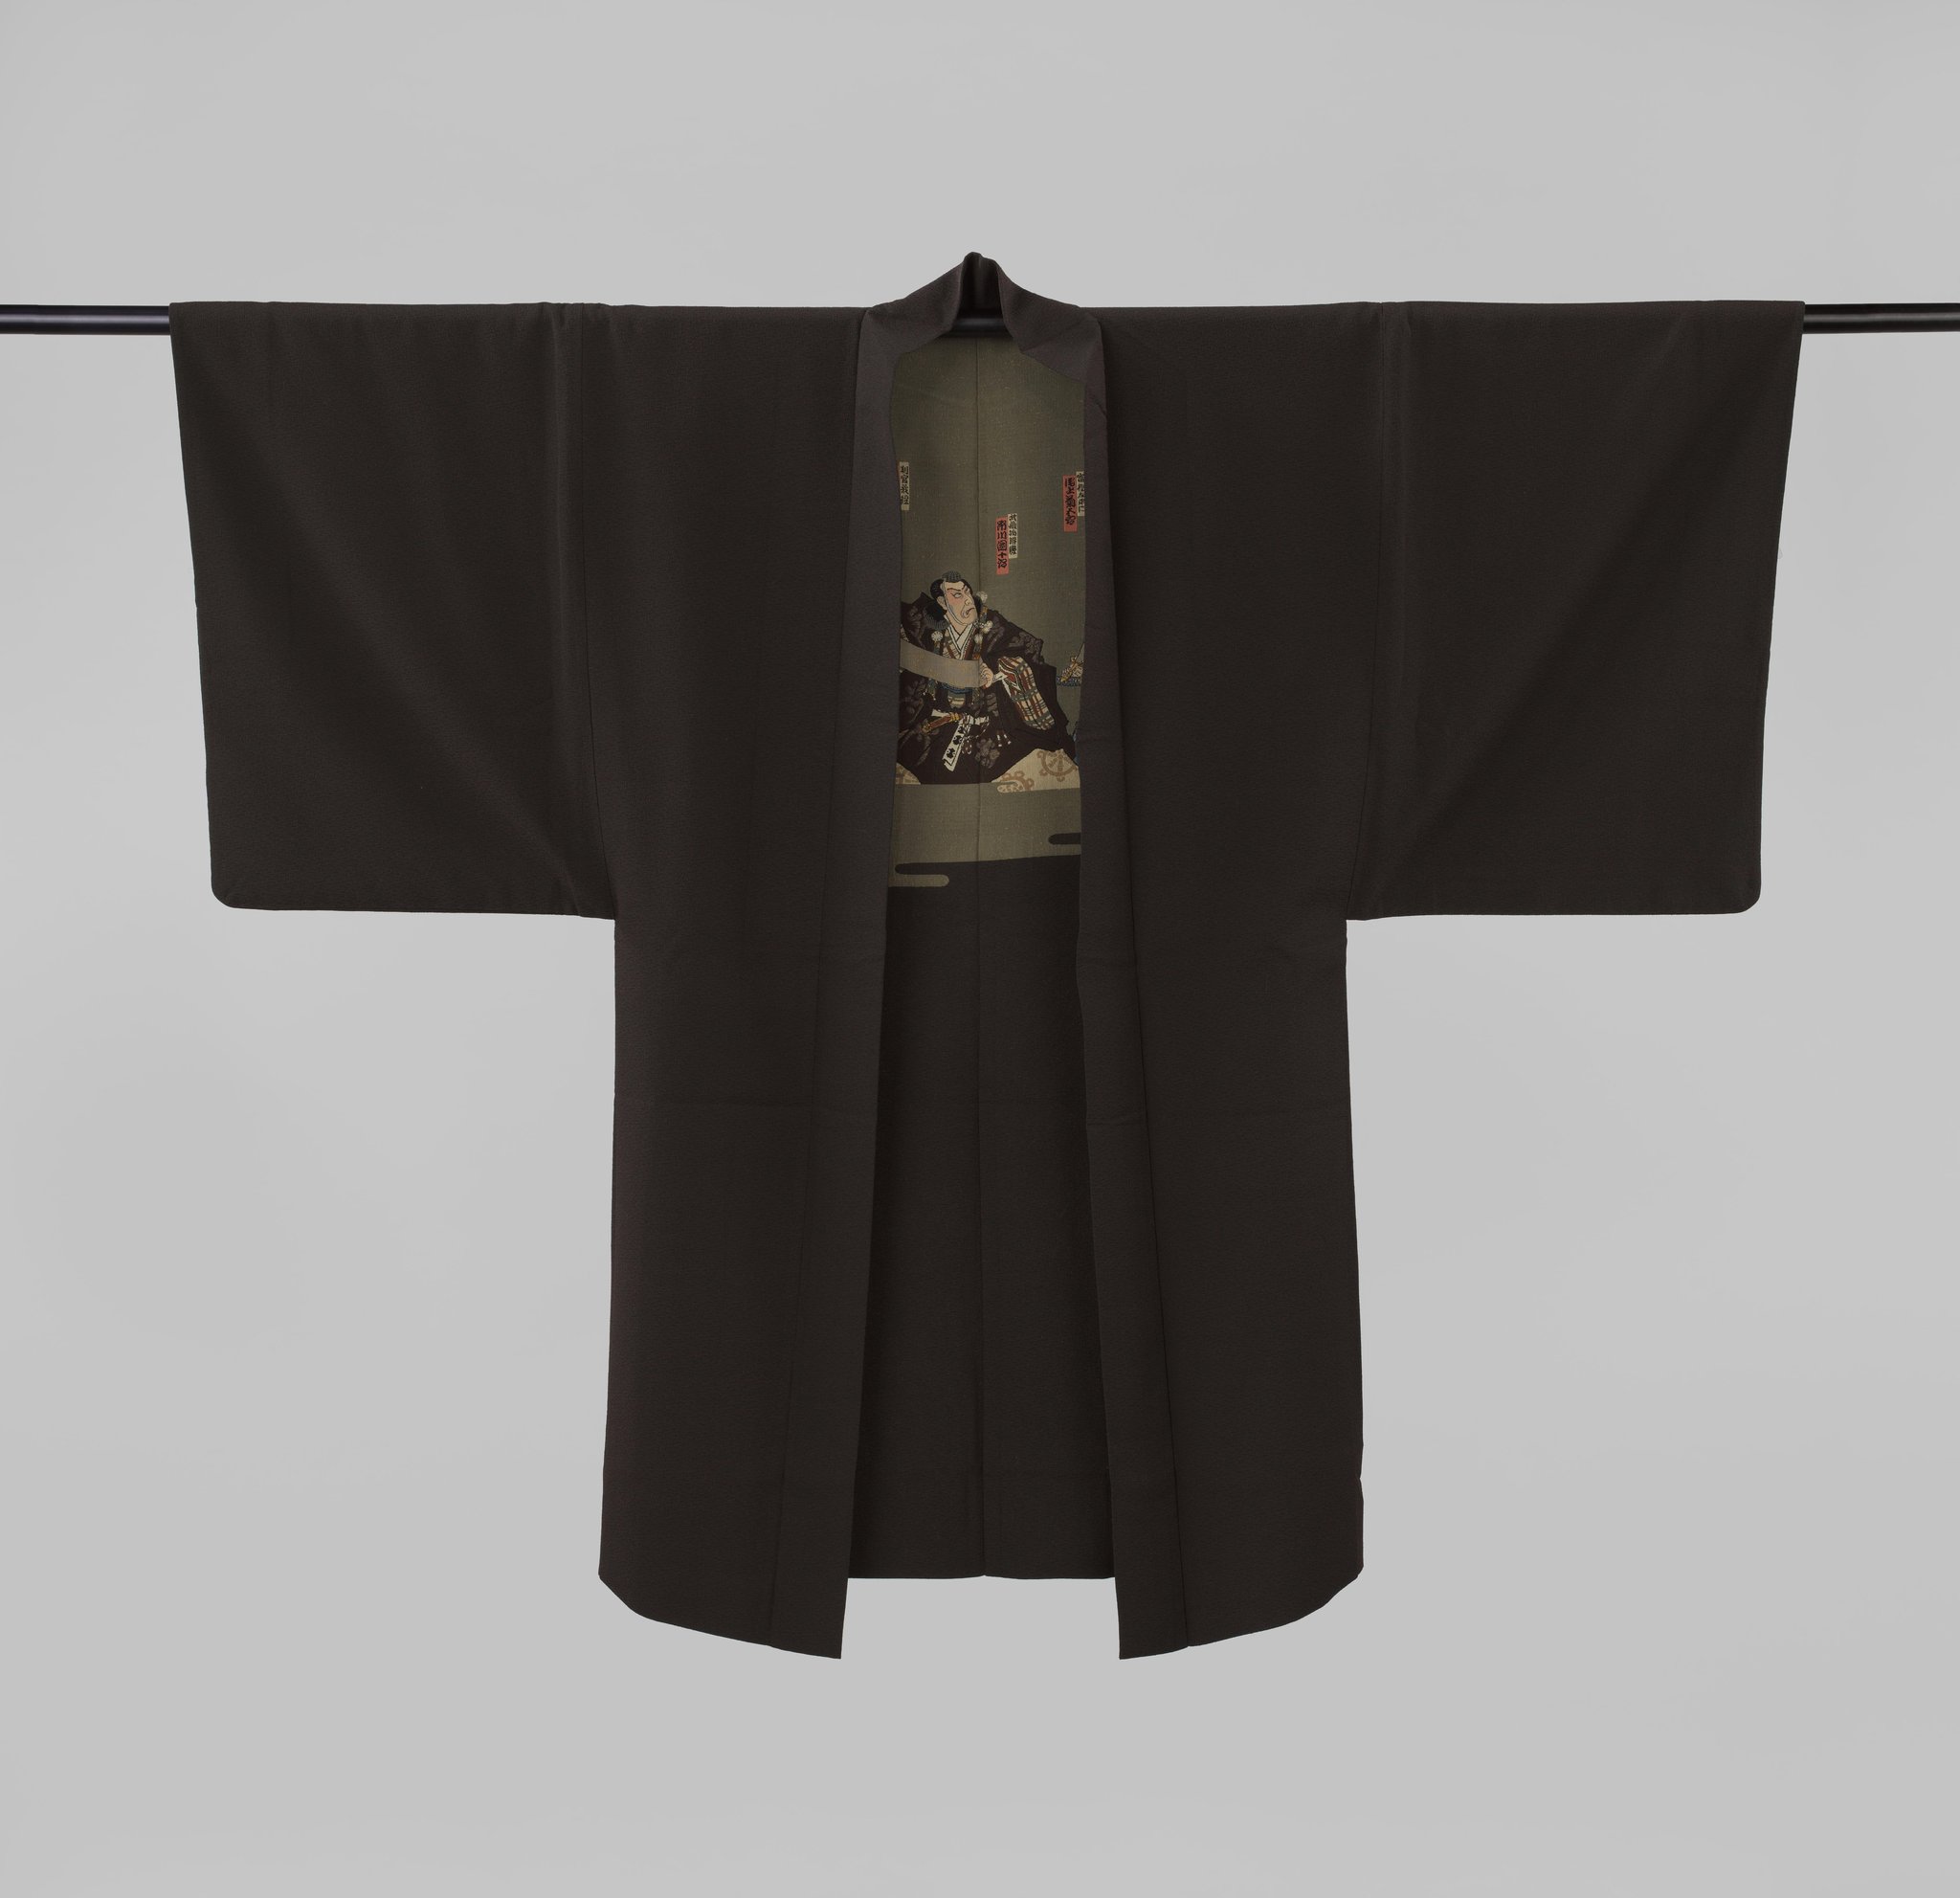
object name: kimono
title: Muso-haori voor mannen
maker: Anonymous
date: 1920-1940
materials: silk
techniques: weave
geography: japan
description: Benkei reading the subscription list at the barrier. Single woven turtle crest.